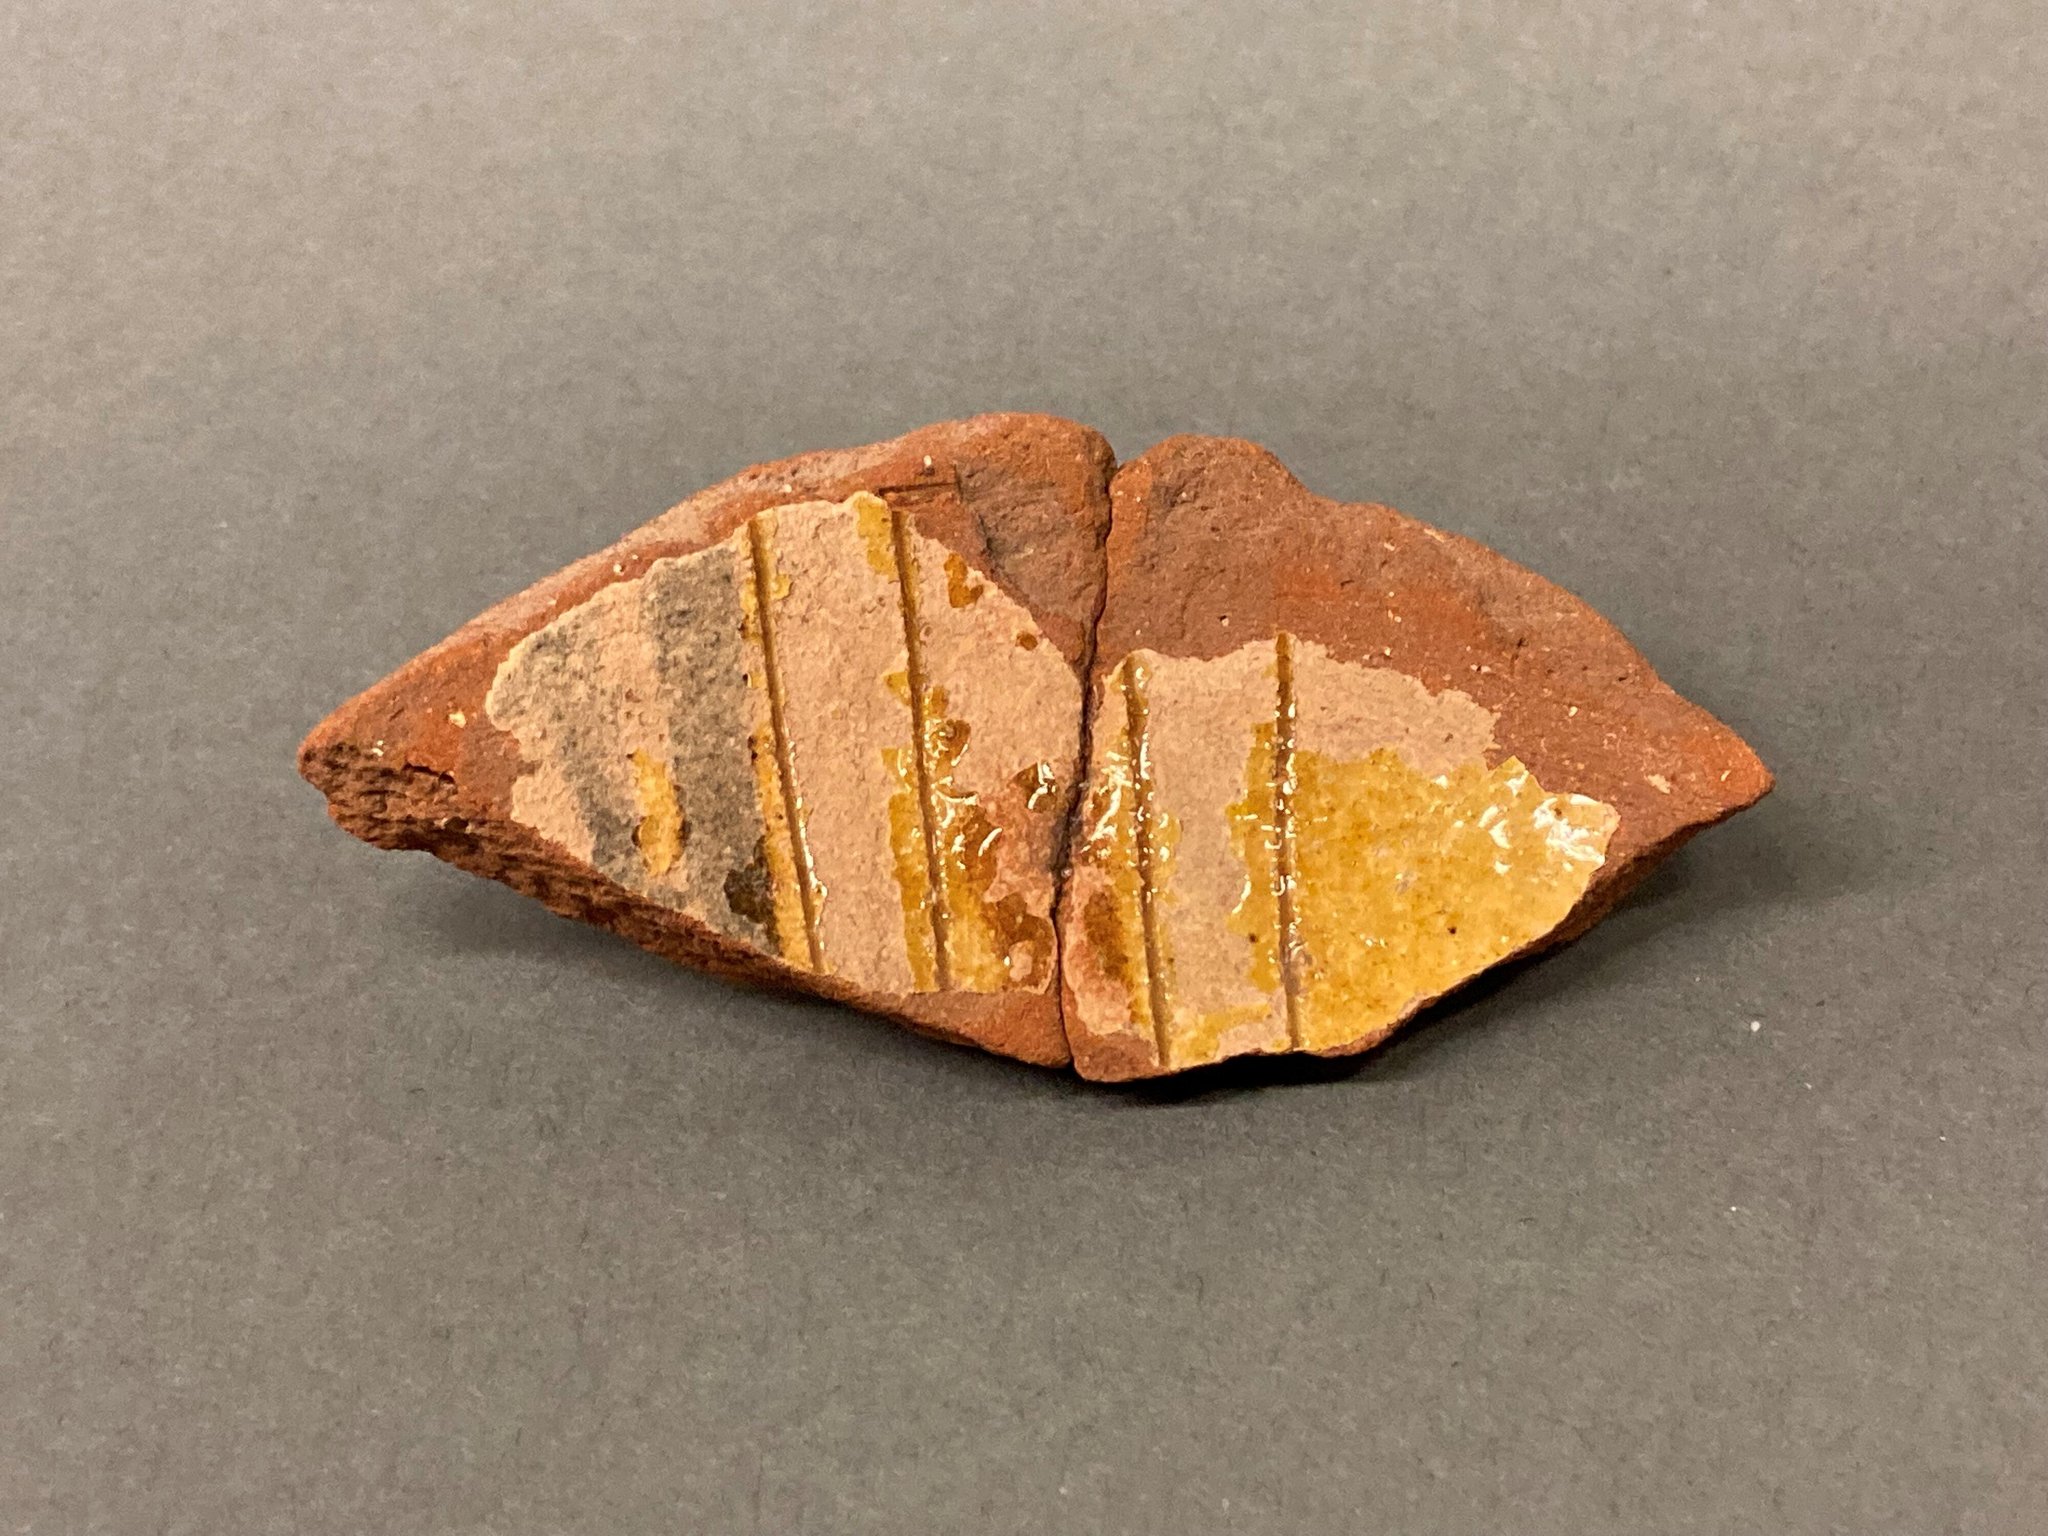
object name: fragment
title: Ceramic Fragment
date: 1301-1500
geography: egypt